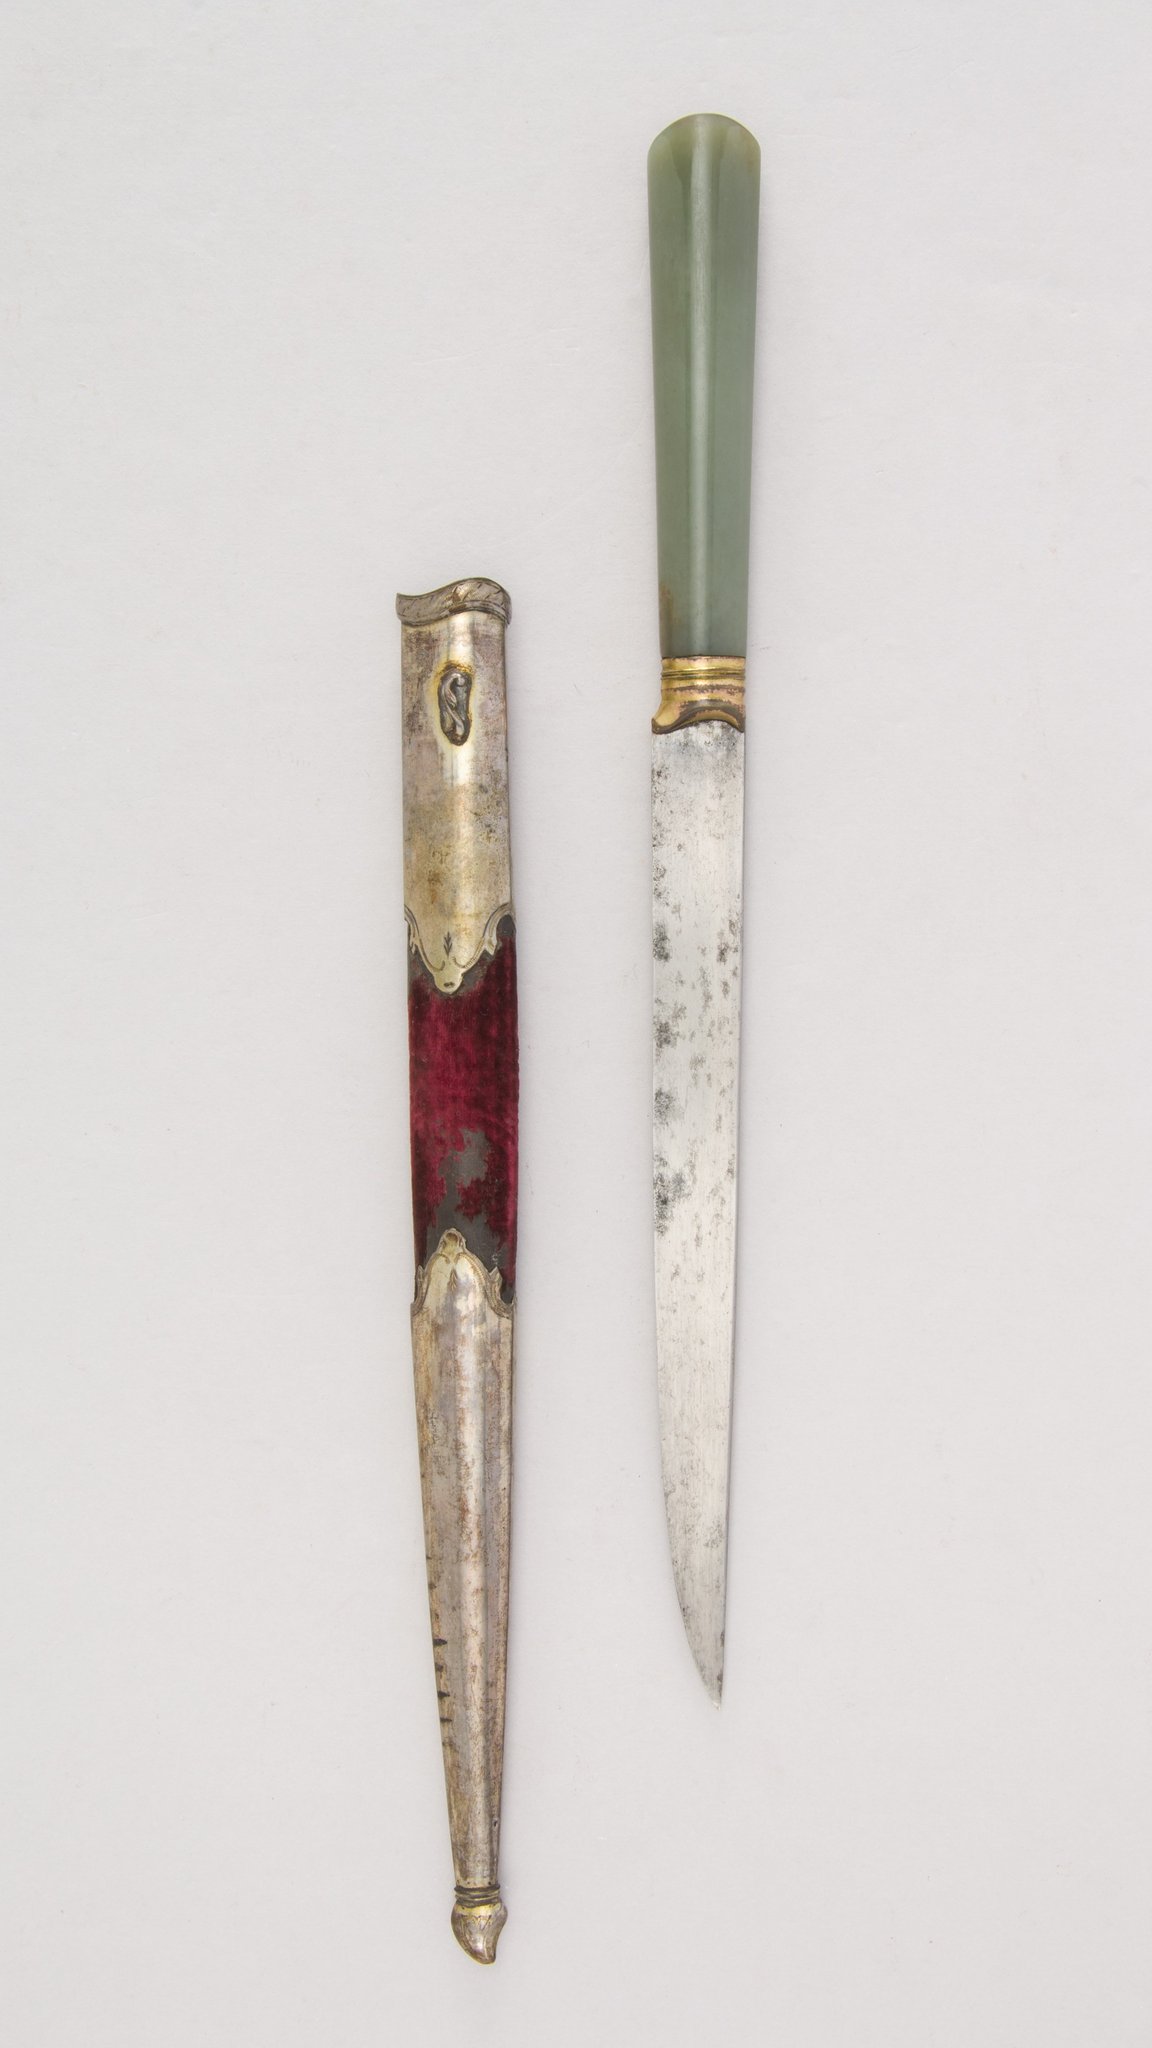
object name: knife with sheath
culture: turkish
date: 1801-1900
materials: jade, silver, steel, velvet, wood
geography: turkey